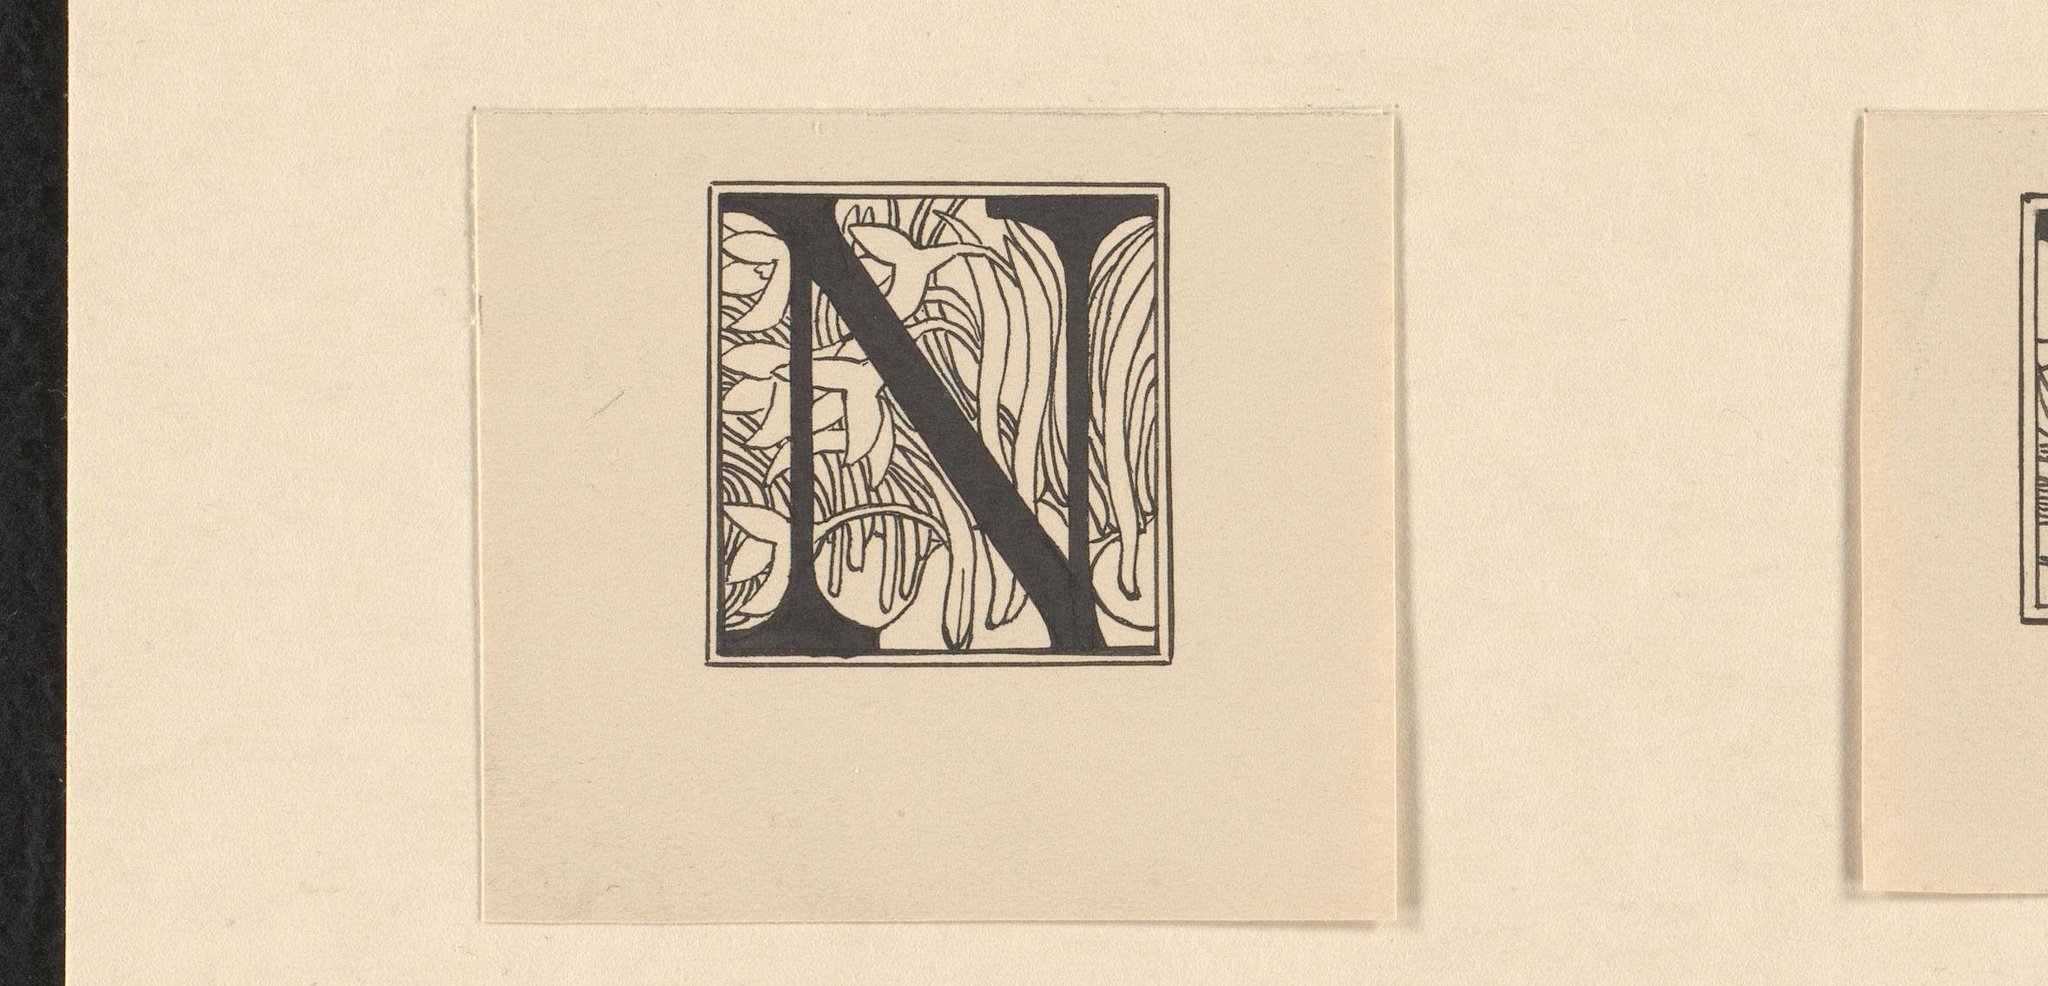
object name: boekillustratie ontwerp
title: Initiaal N gedecoreerd met sneeuwklokjes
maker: edzard koning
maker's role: draughtsman, print maker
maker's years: 1869-1954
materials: ink, paper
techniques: brush, pen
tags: flowers: snowdrop, initial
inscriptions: collector's mark: Lugt 2228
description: Mogelijk een ontwerp voor: Eeden, Frederik van. De kleine Johannes. Den Haag: Mouton & Co., 1898. Niet gebruikt in de definitieve uitgave.